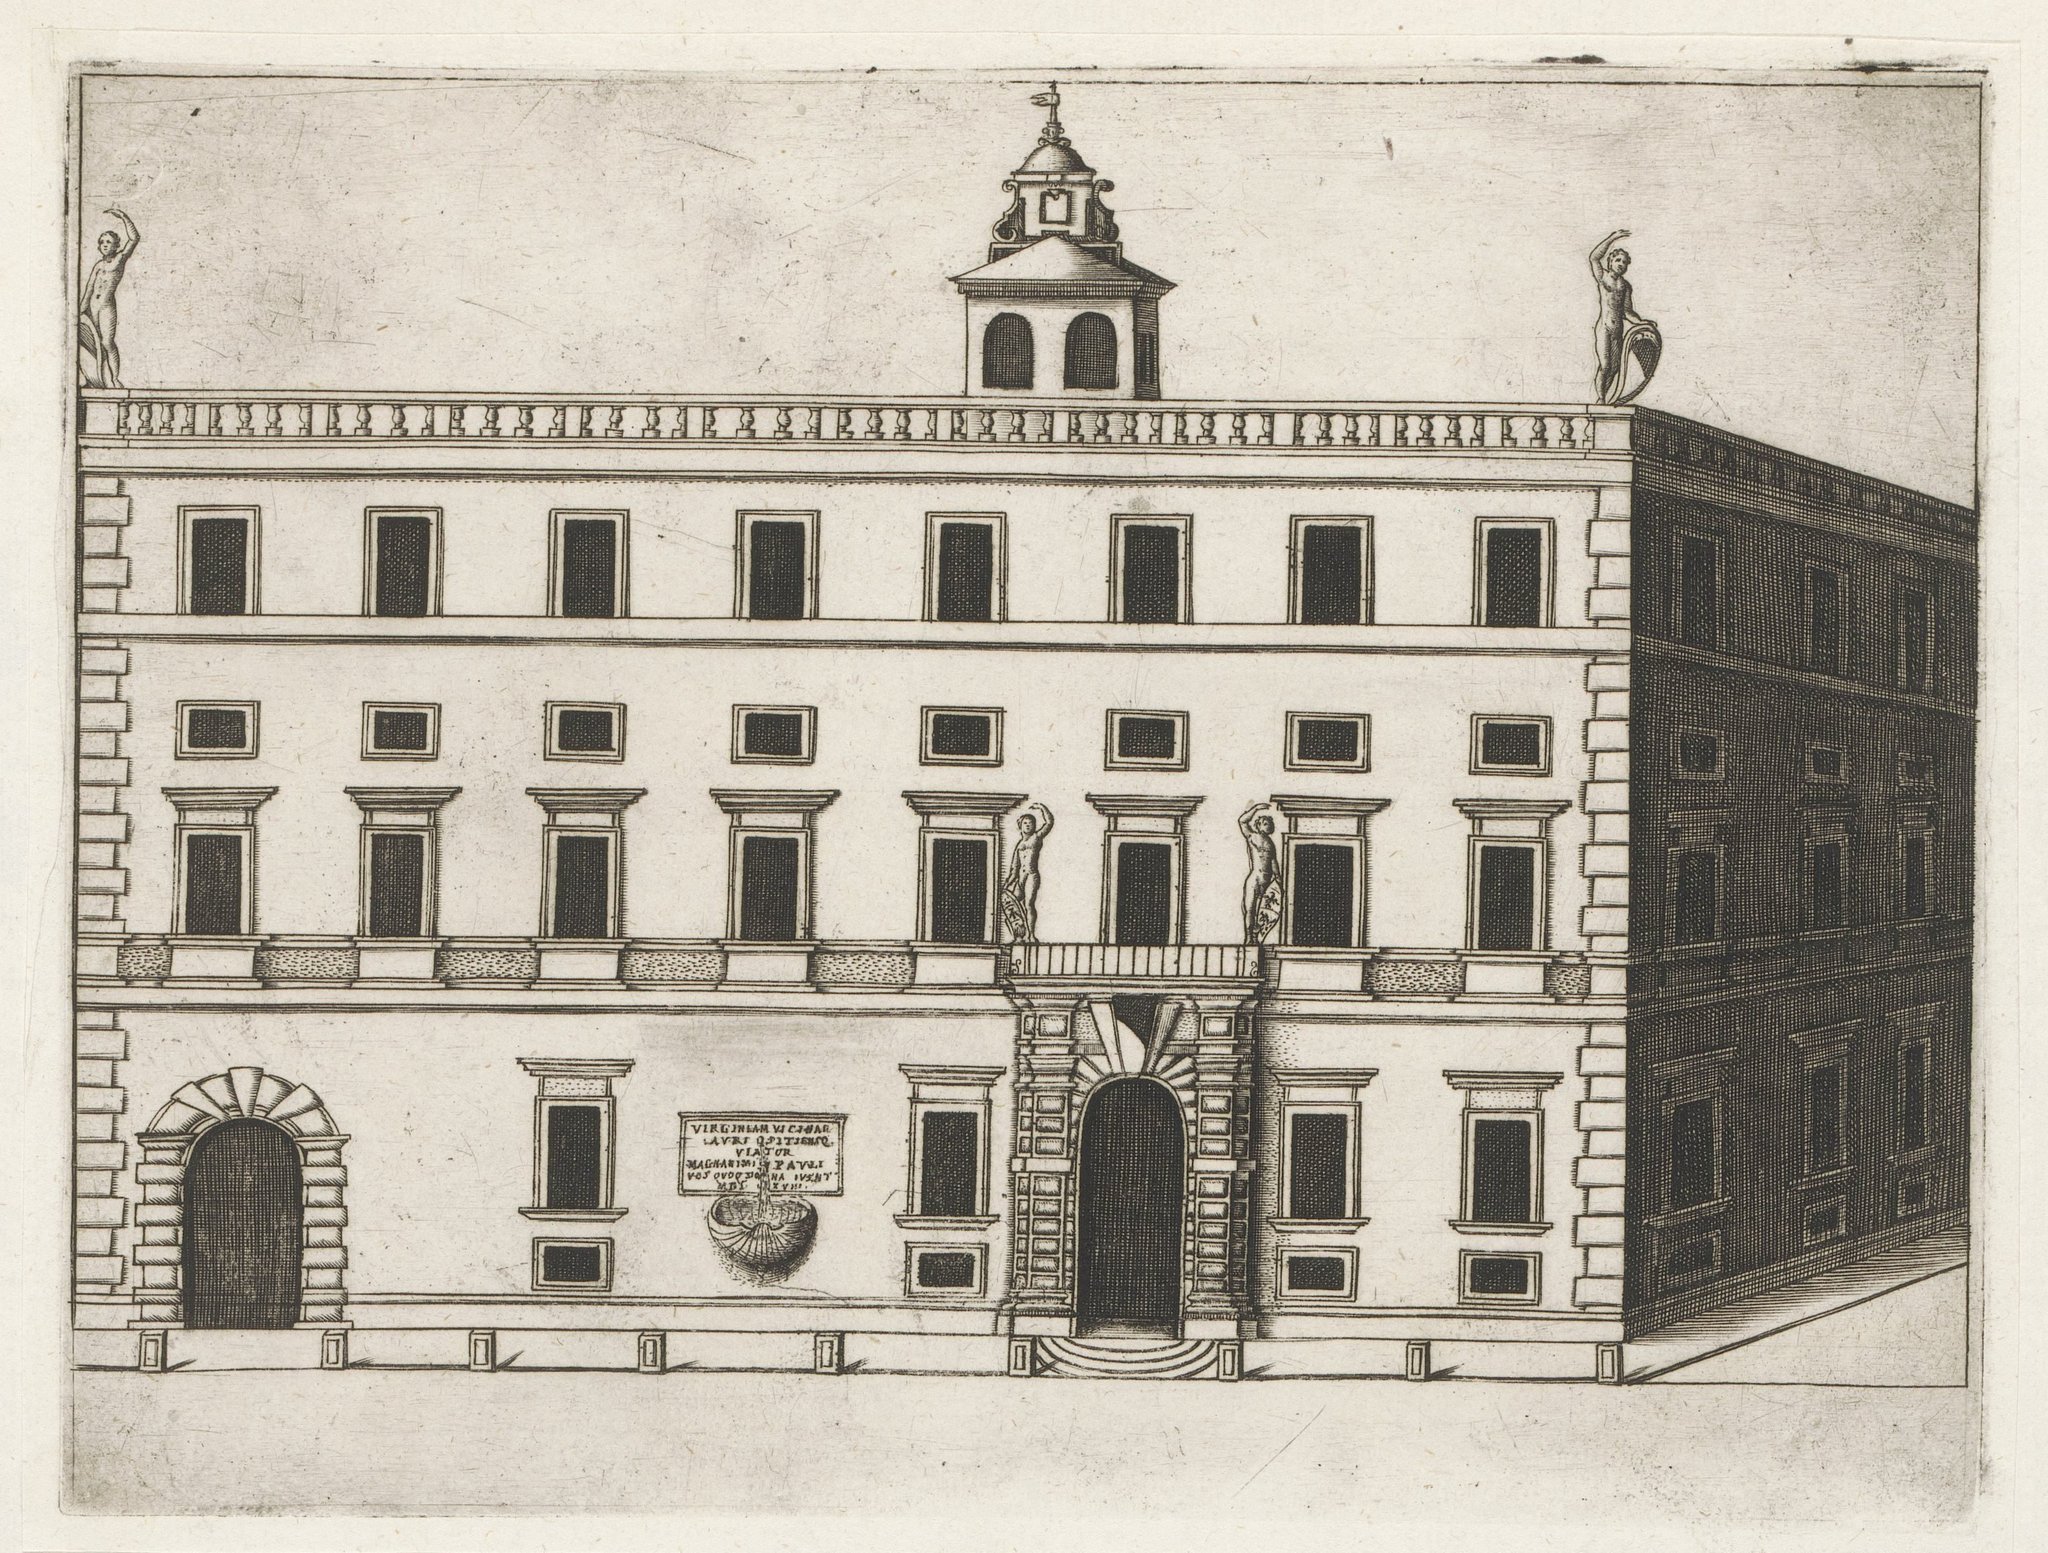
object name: print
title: Palazzi diversi nel' alma cità di Roma, et altre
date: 1638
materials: paper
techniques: etching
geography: rome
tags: hôtel, i.e. small palace in city, façade (of house or building)